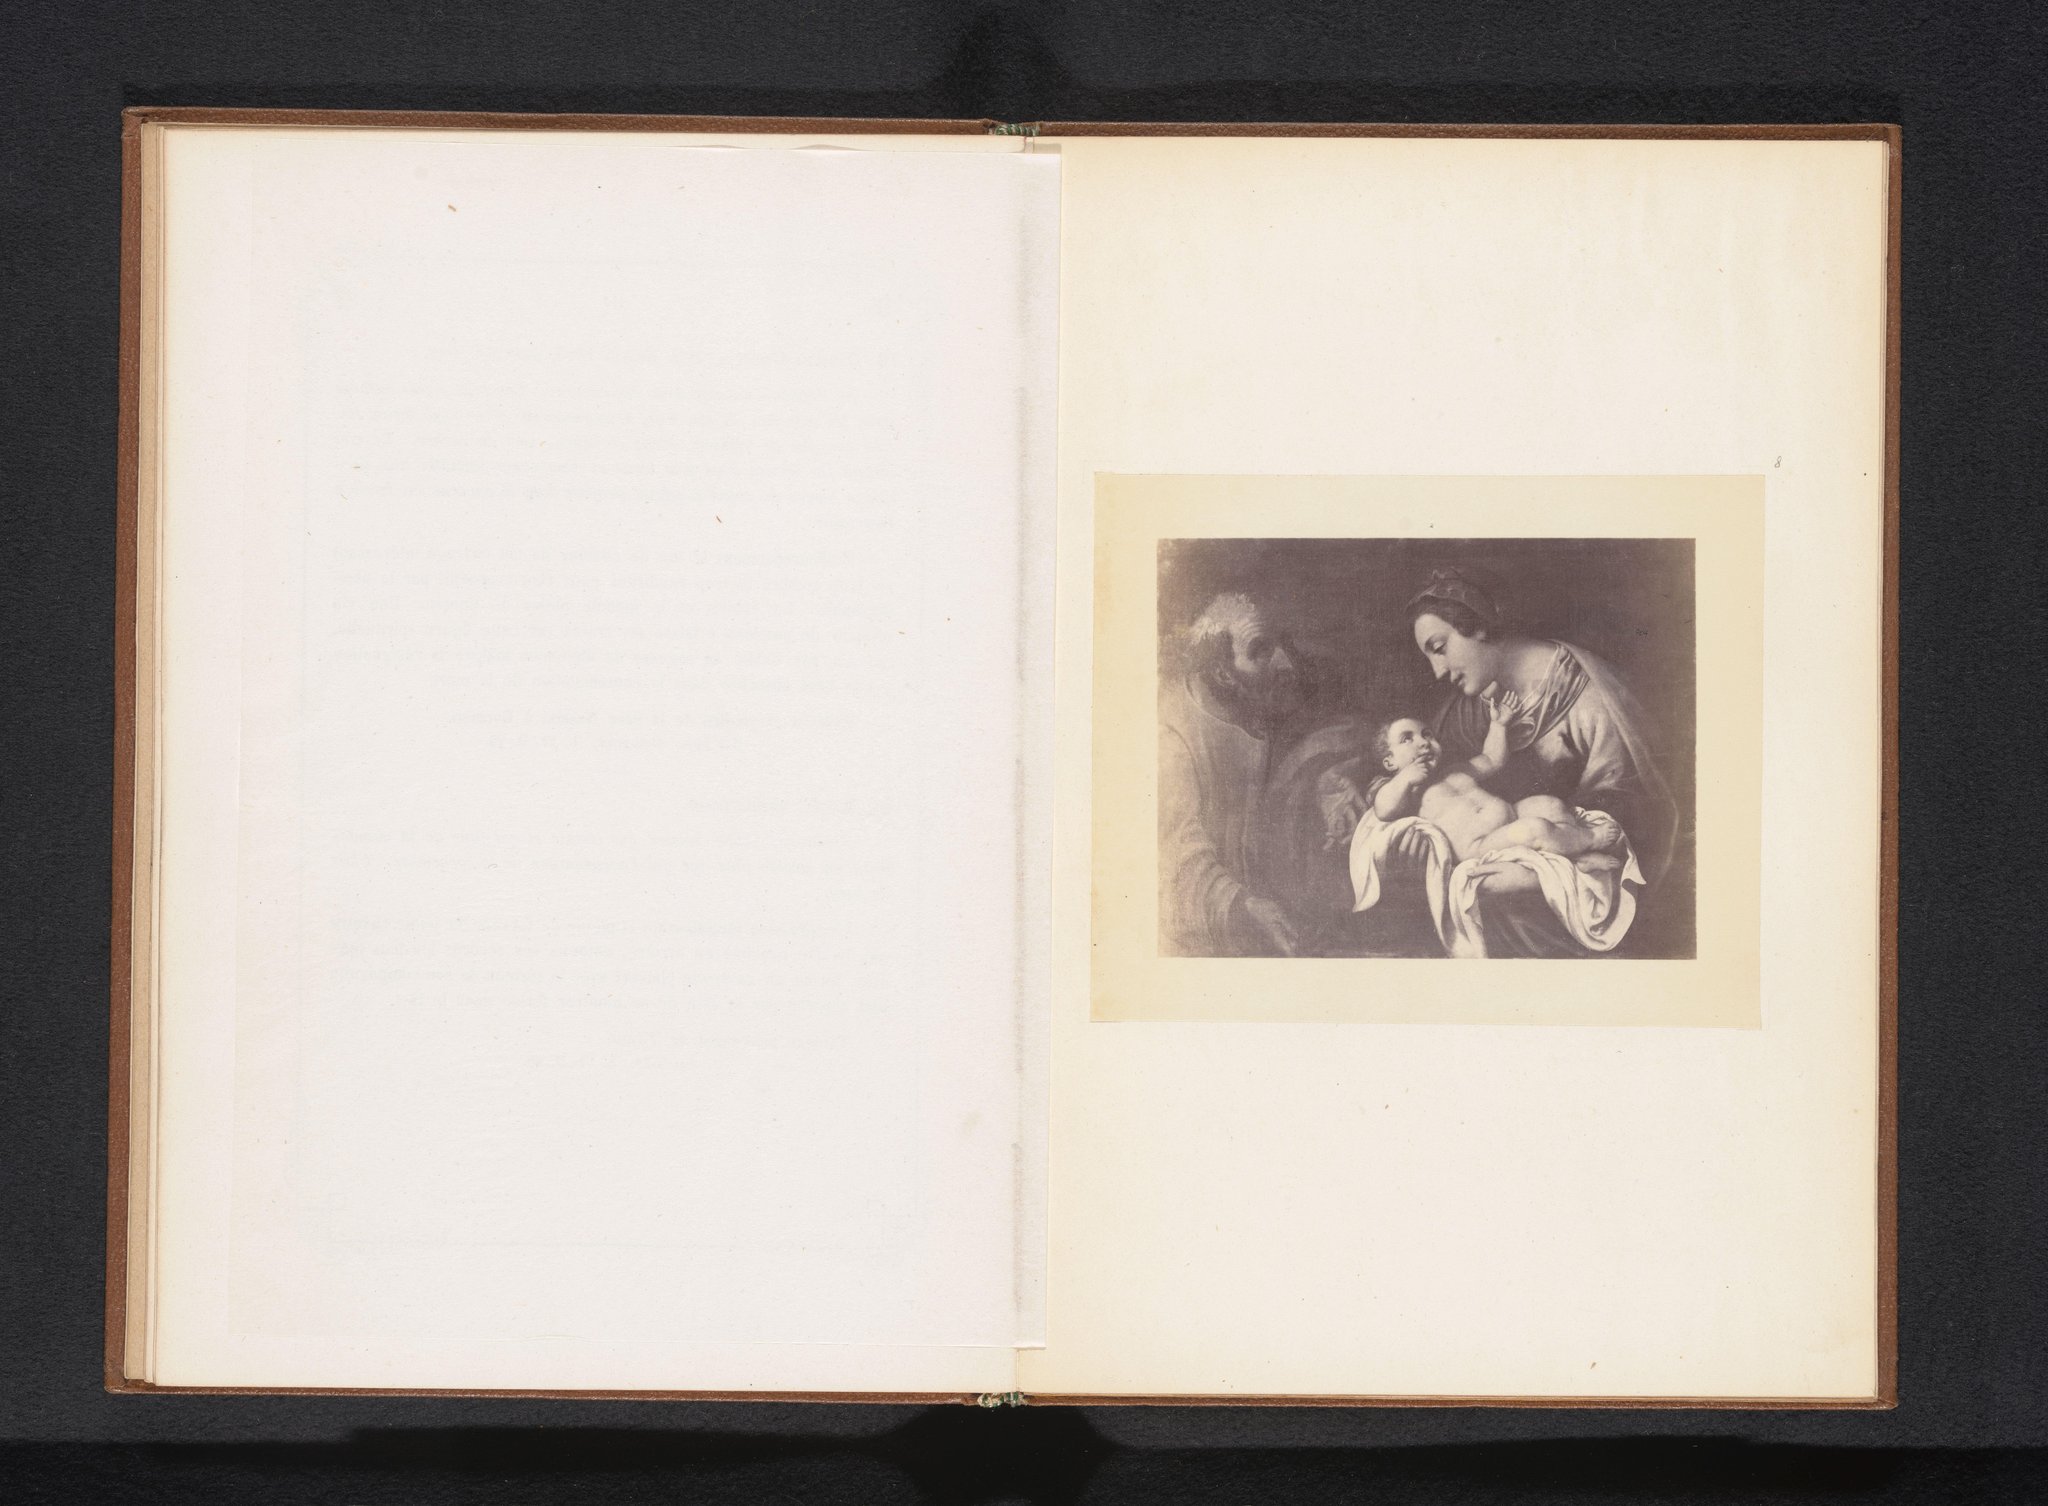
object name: photograph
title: Fotoreproductie van een schilderij van de vlucht naar Egypte, mogelijk door Guercino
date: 1856-1866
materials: photographic support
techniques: albumen print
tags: flight into egypt and miracles during the journey, picture, painting